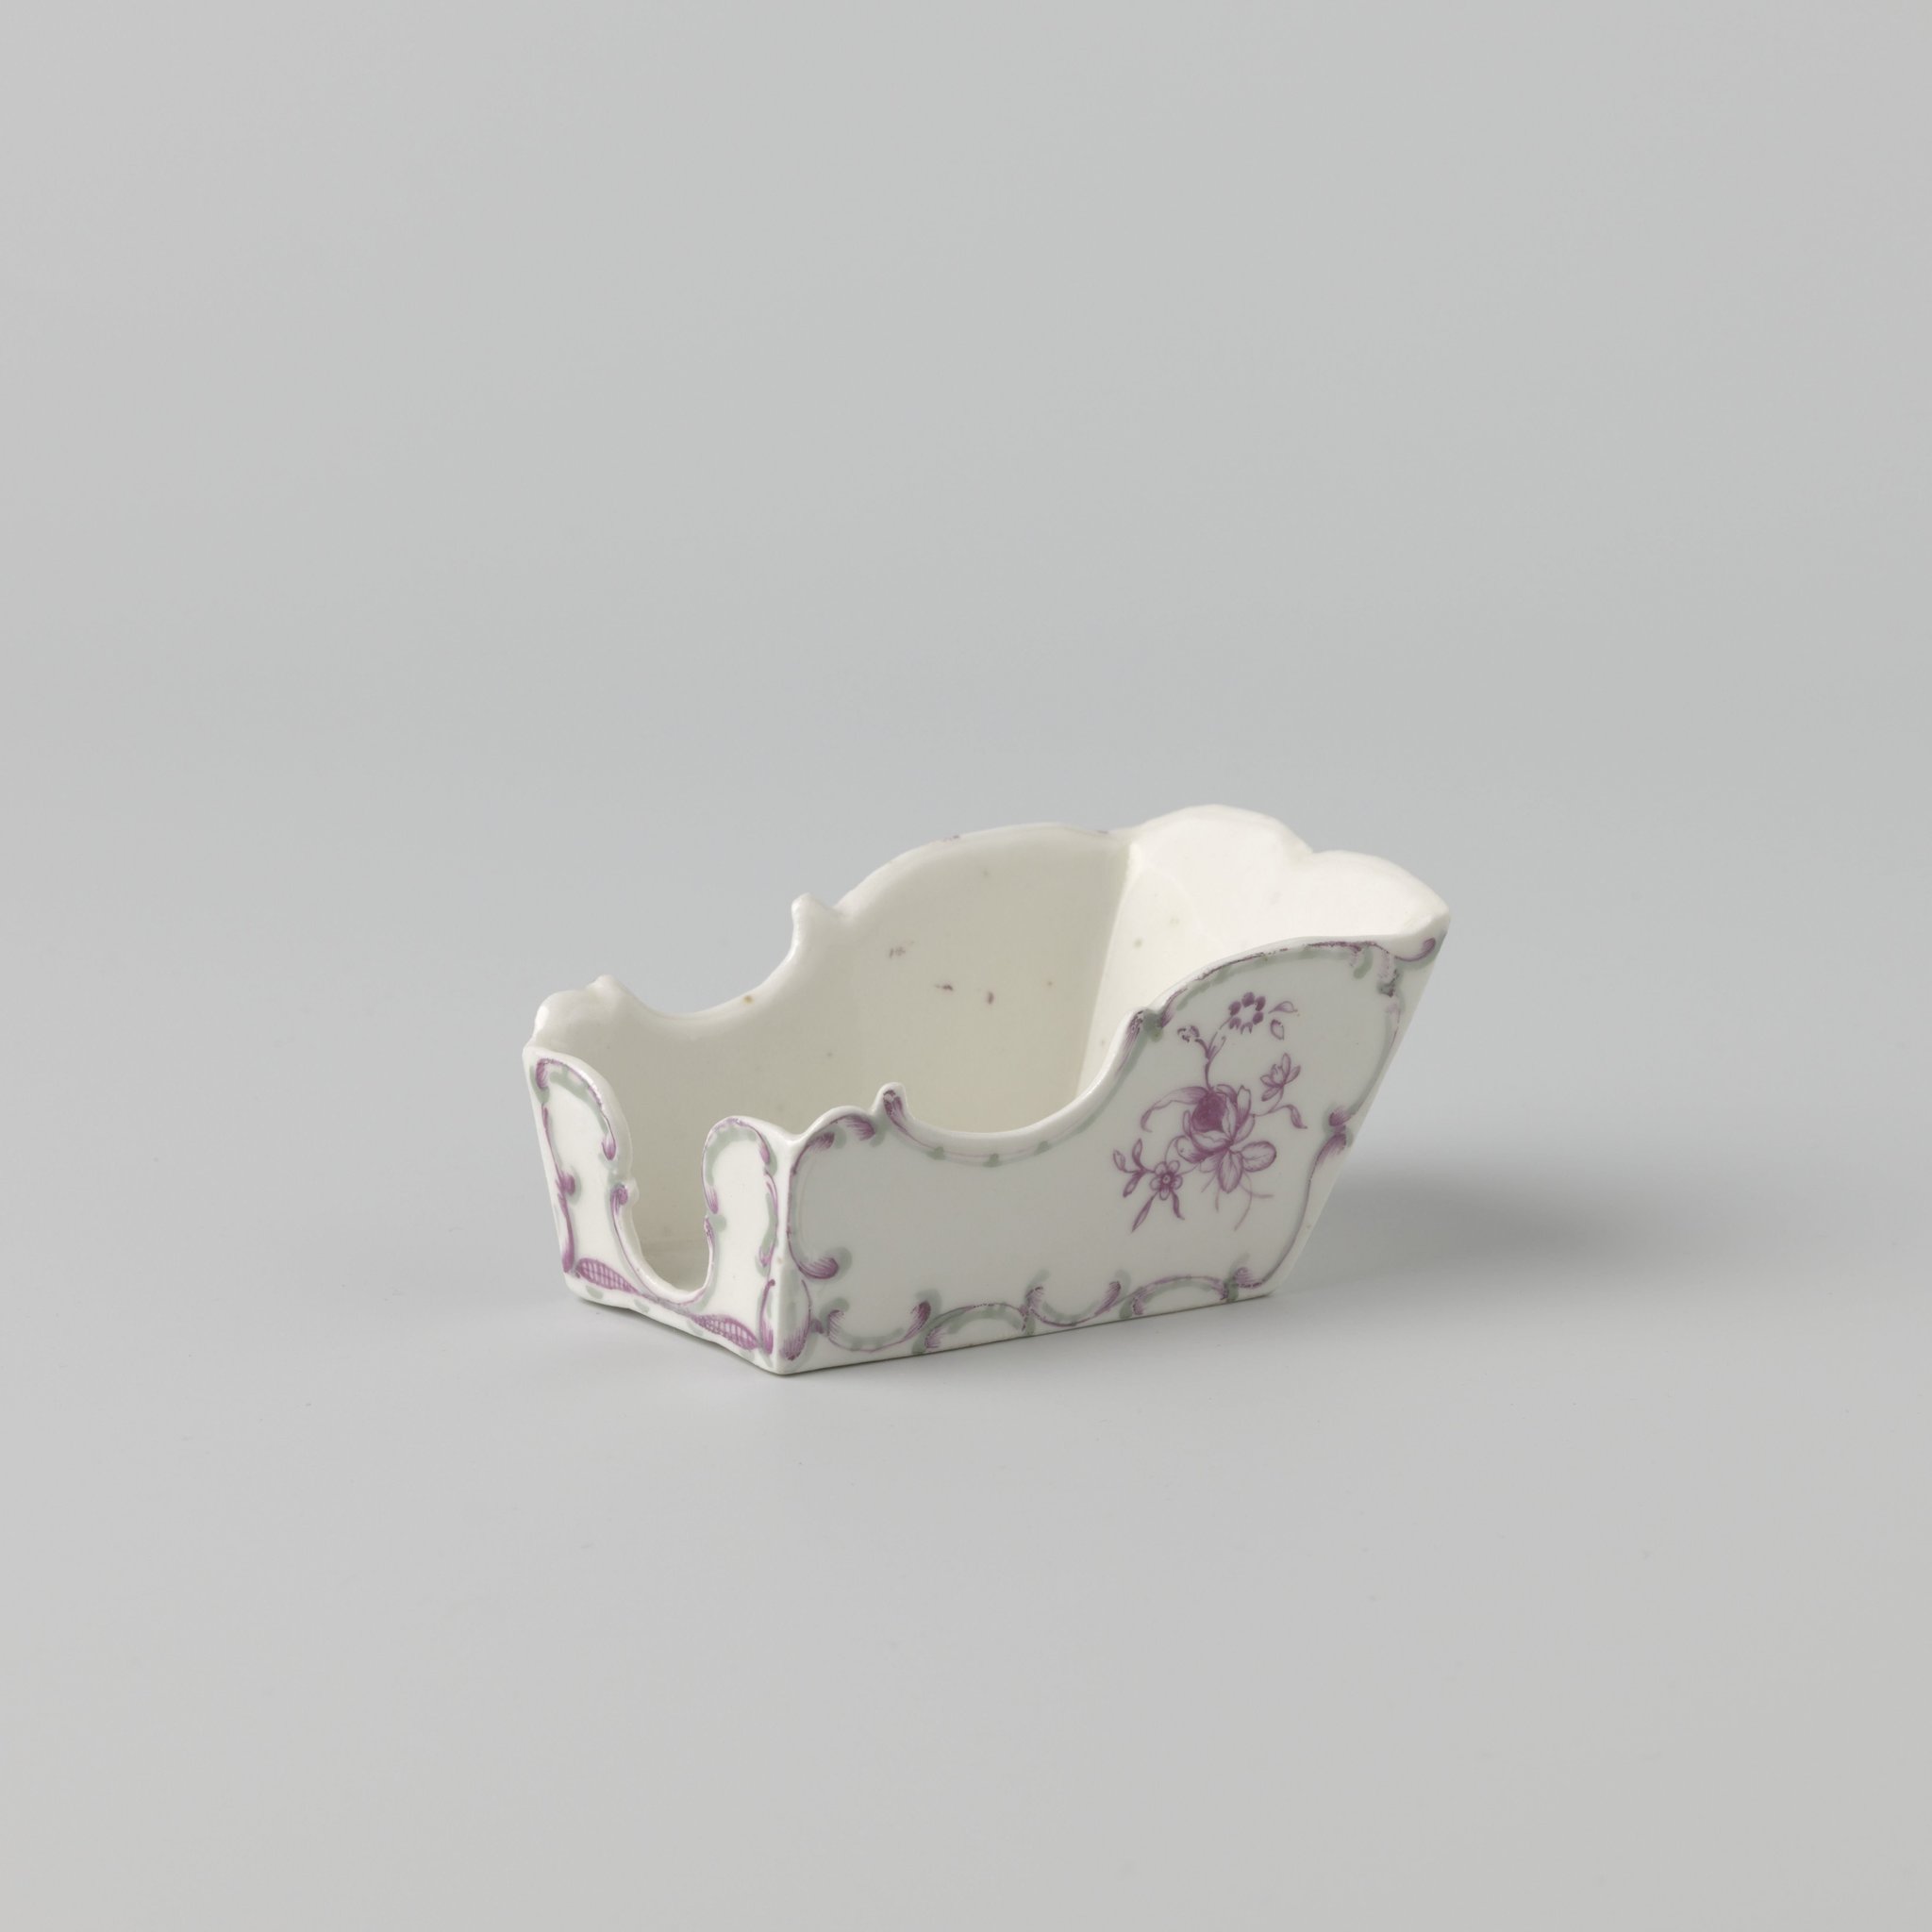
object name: pijpenslee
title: Pijpenslee van porselein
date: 1774-1784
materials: porcelain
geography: loosdrecht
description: Two pipe bowls. Porcelain. Loosdrecht, c. 1778 - 1782. Factory of Joannes de Mol.